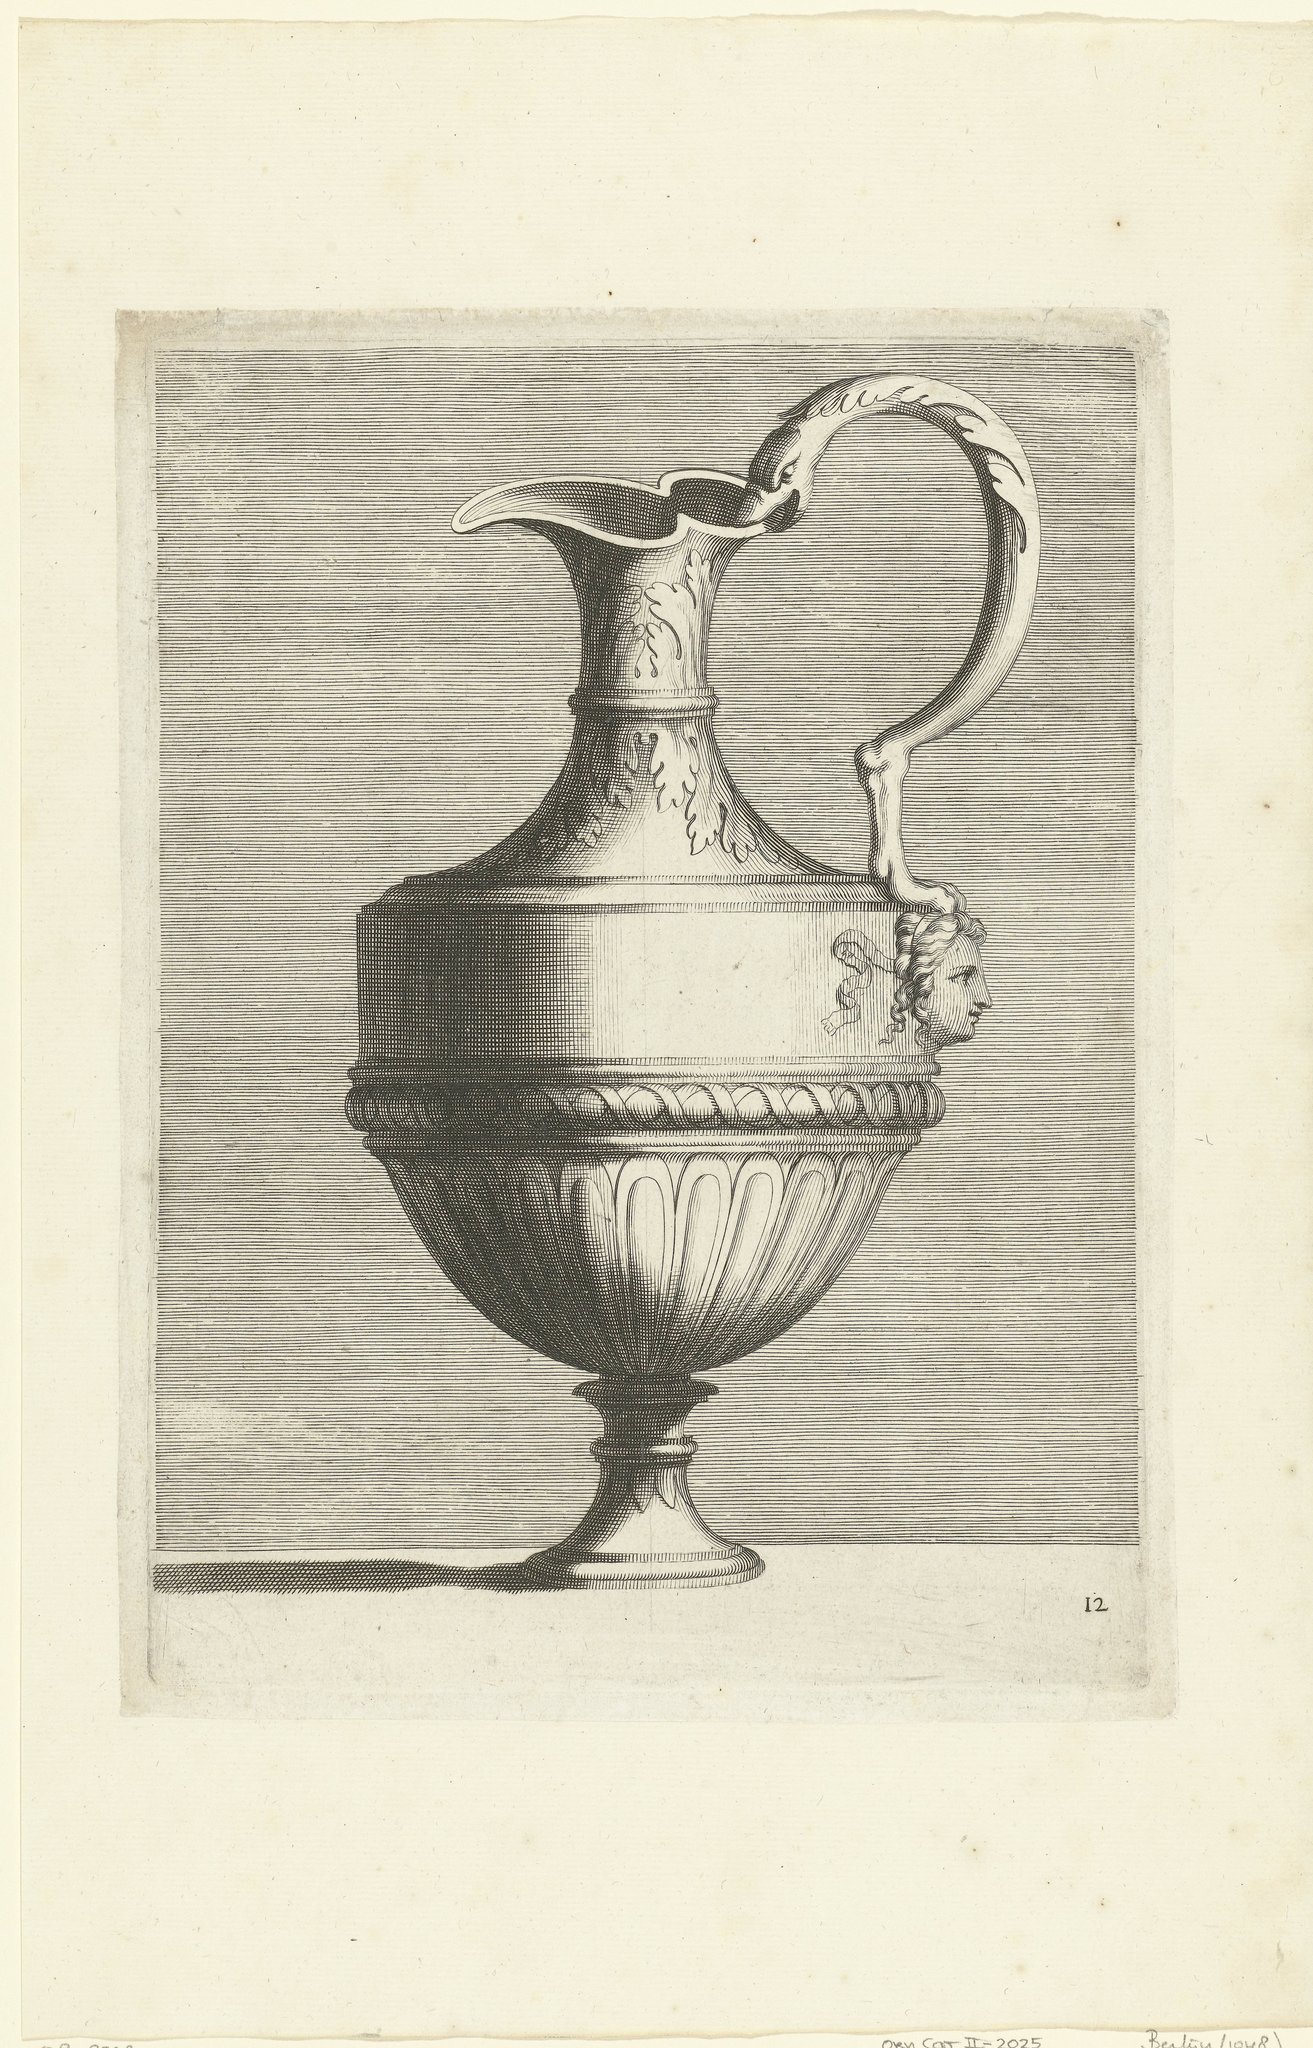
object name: ornament print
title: Schenkkan met bladeren om de hals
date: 1657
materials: paper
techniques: engraving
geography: france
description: De onderkant is versierd met staafwerk, het handvat rust met een dierenpoot op een masker en loopt bovenaan uit in een slangenkop. Blad 12 uit serie van 24 bladen, genummerd: 1-21, 23-25. Deze serie werd opgevolgd door de serie Second Livre de Vases, bestaande uit 25 bladen, waarin de nummering doorloopt.